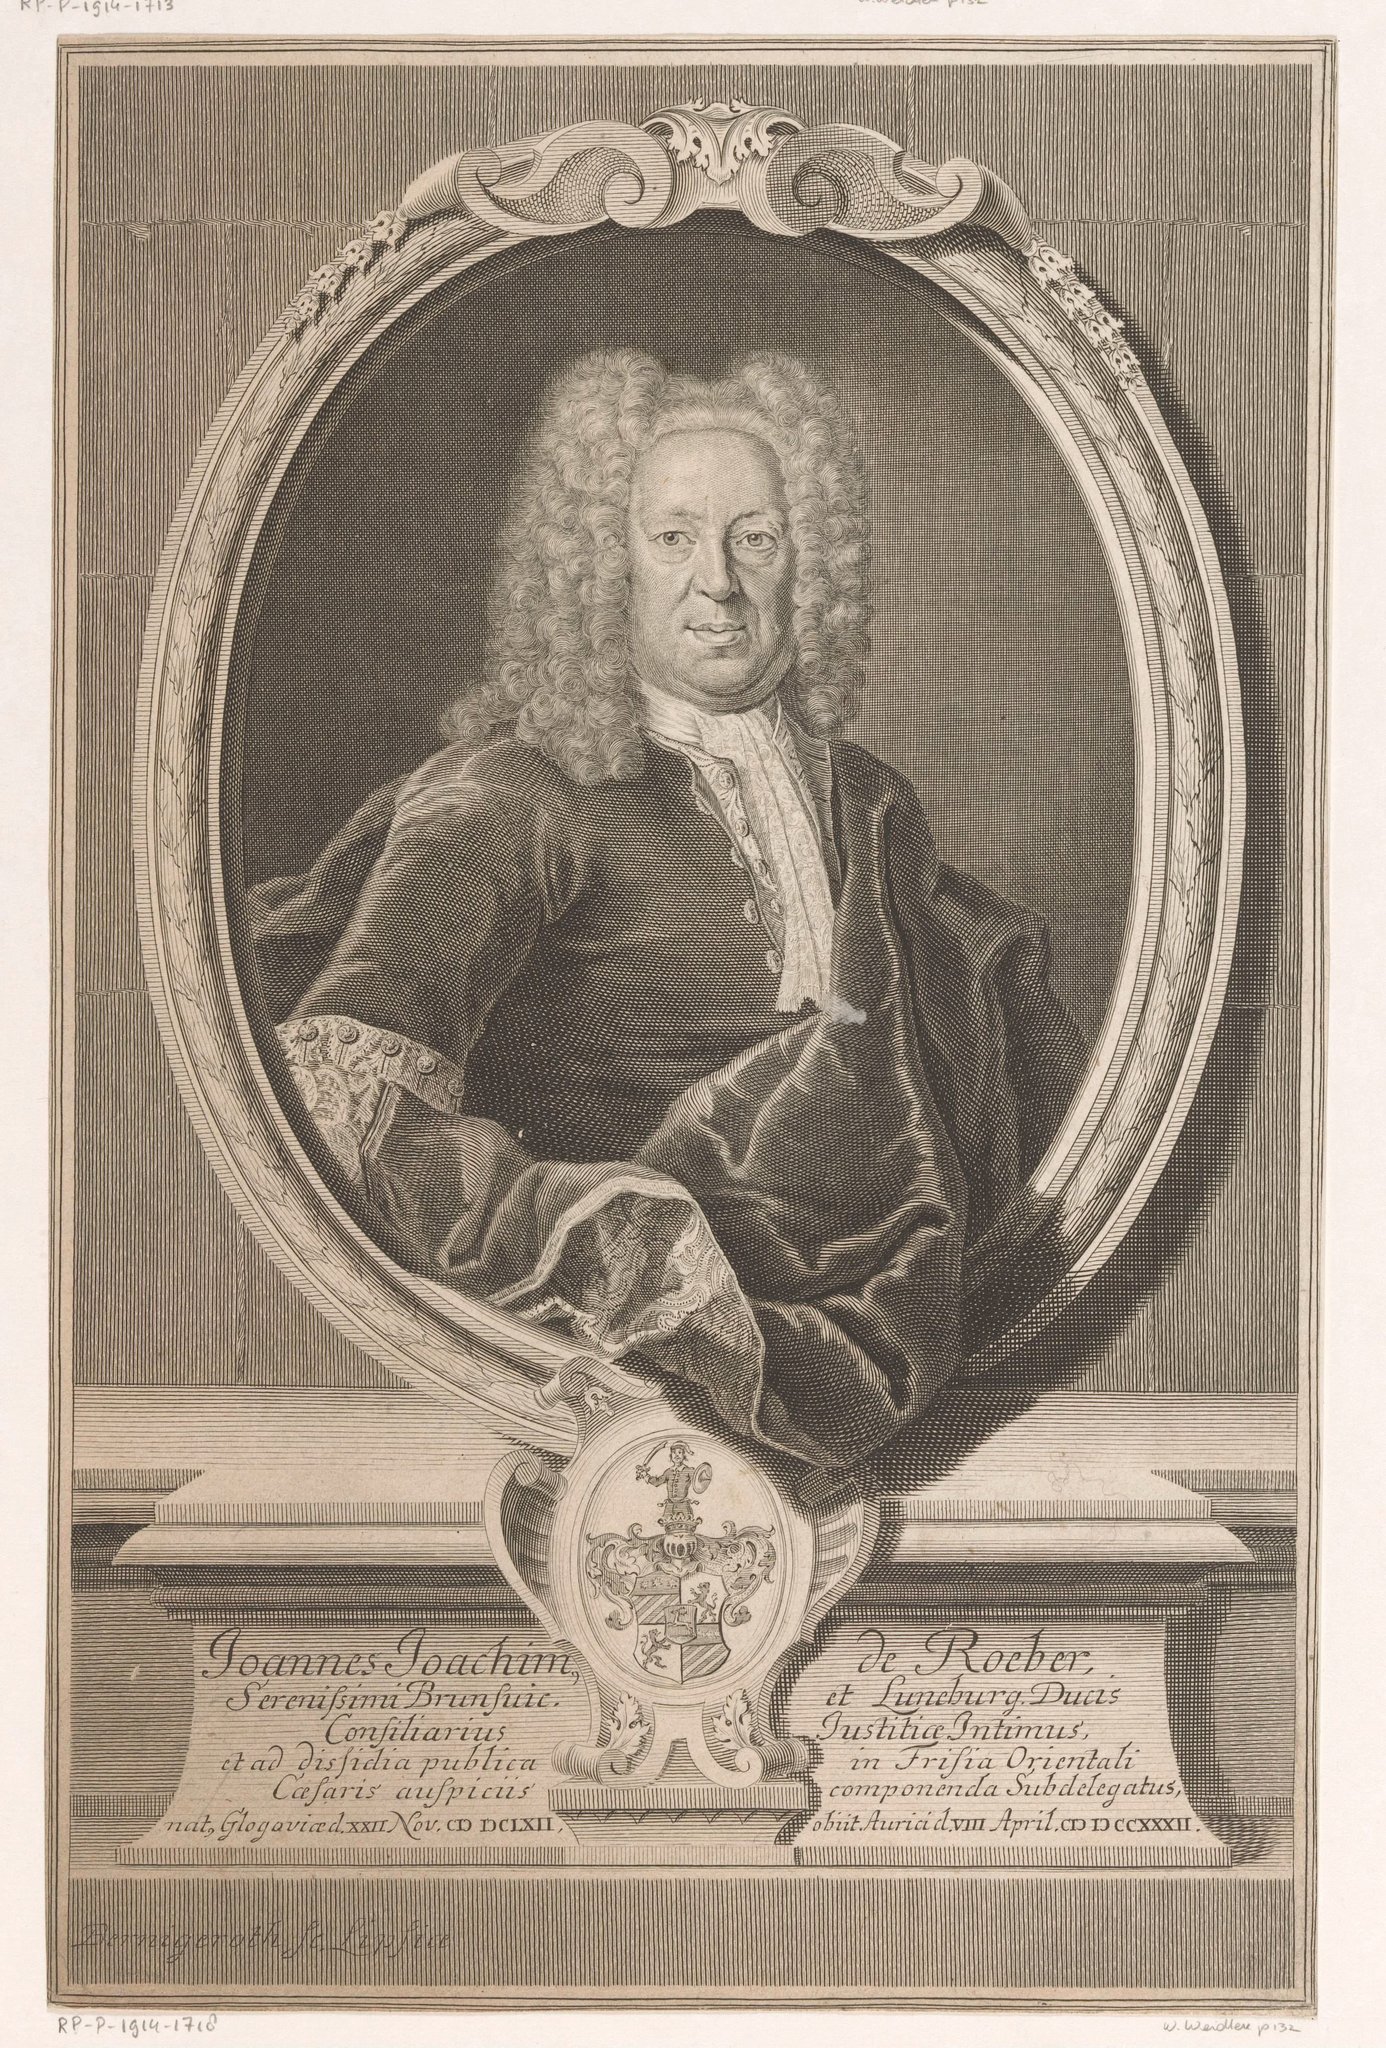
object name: print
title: Portret van Johann Joachim von Roeber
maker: martin bernigeroth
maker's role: print maker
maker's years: 1670-1733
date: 1732-1733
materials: paper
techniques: engraving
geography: leipzig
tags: historical persons, armorial bearing, heraldry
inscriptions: collector's mark: Lugt 2228